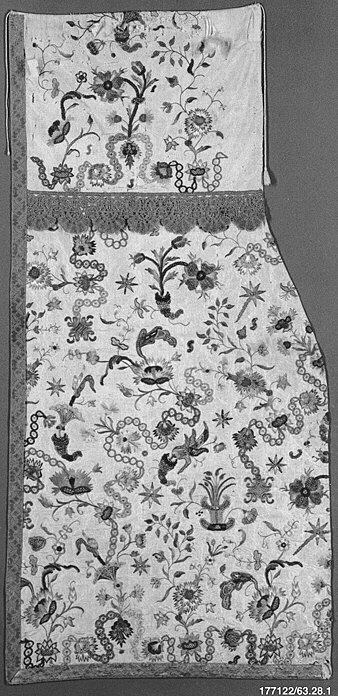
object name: panel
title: Panels (2)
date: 1701-1800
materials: metal thread, silk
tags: flowers